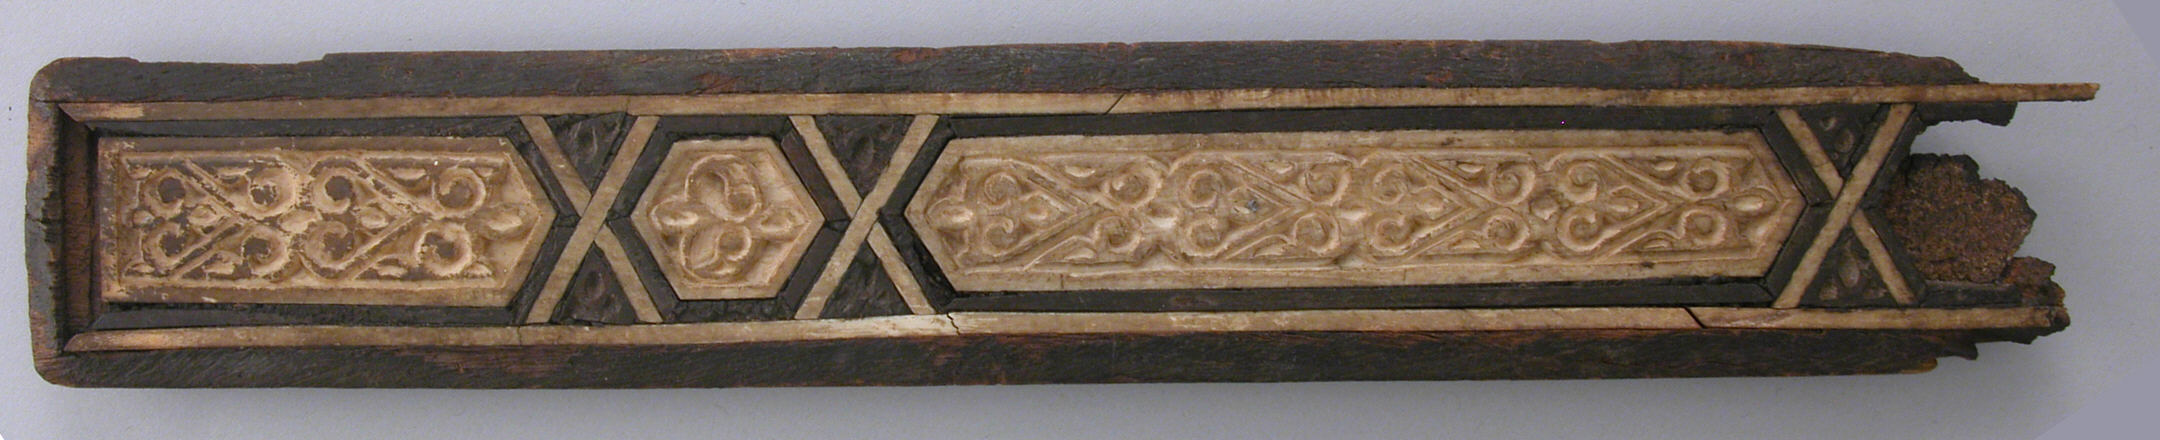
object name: panel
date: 1301-1500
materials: ivory, wood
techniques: carving, inlay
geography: egypt